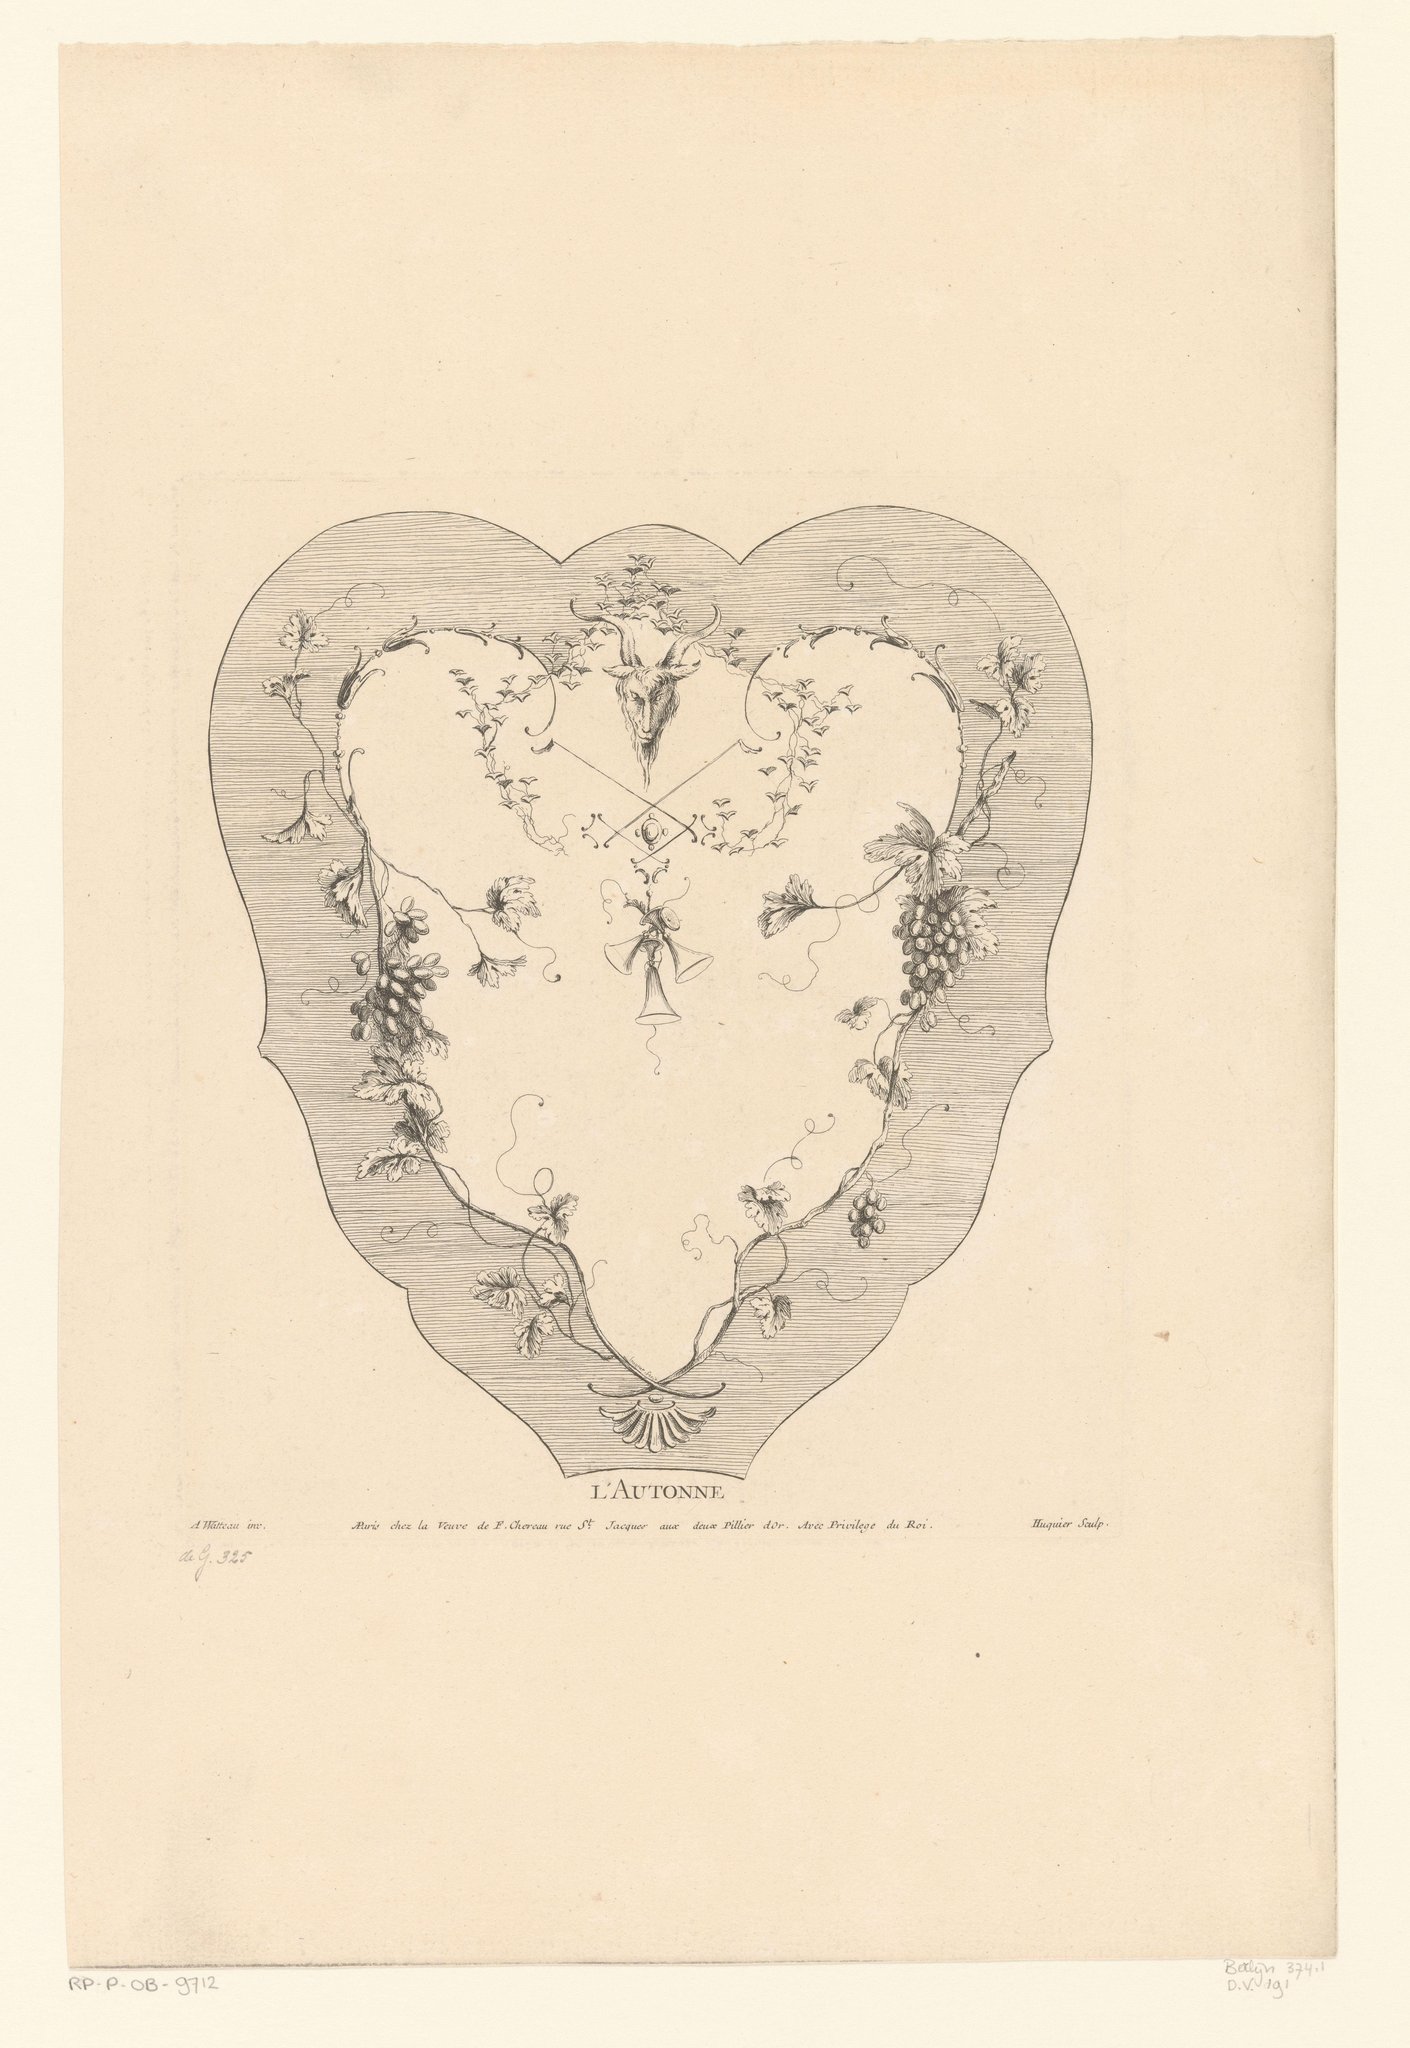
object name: ornament print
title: l'Autonne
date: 1729-1755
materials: paper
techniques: etching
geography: paris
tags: autumn, fall, 'autumnus'; 'autunno' (ripa)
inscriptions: collector's mark: Lugt 2228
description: Hartvormige omlijsting met drie glazen, een geitenkop en druivenranken.